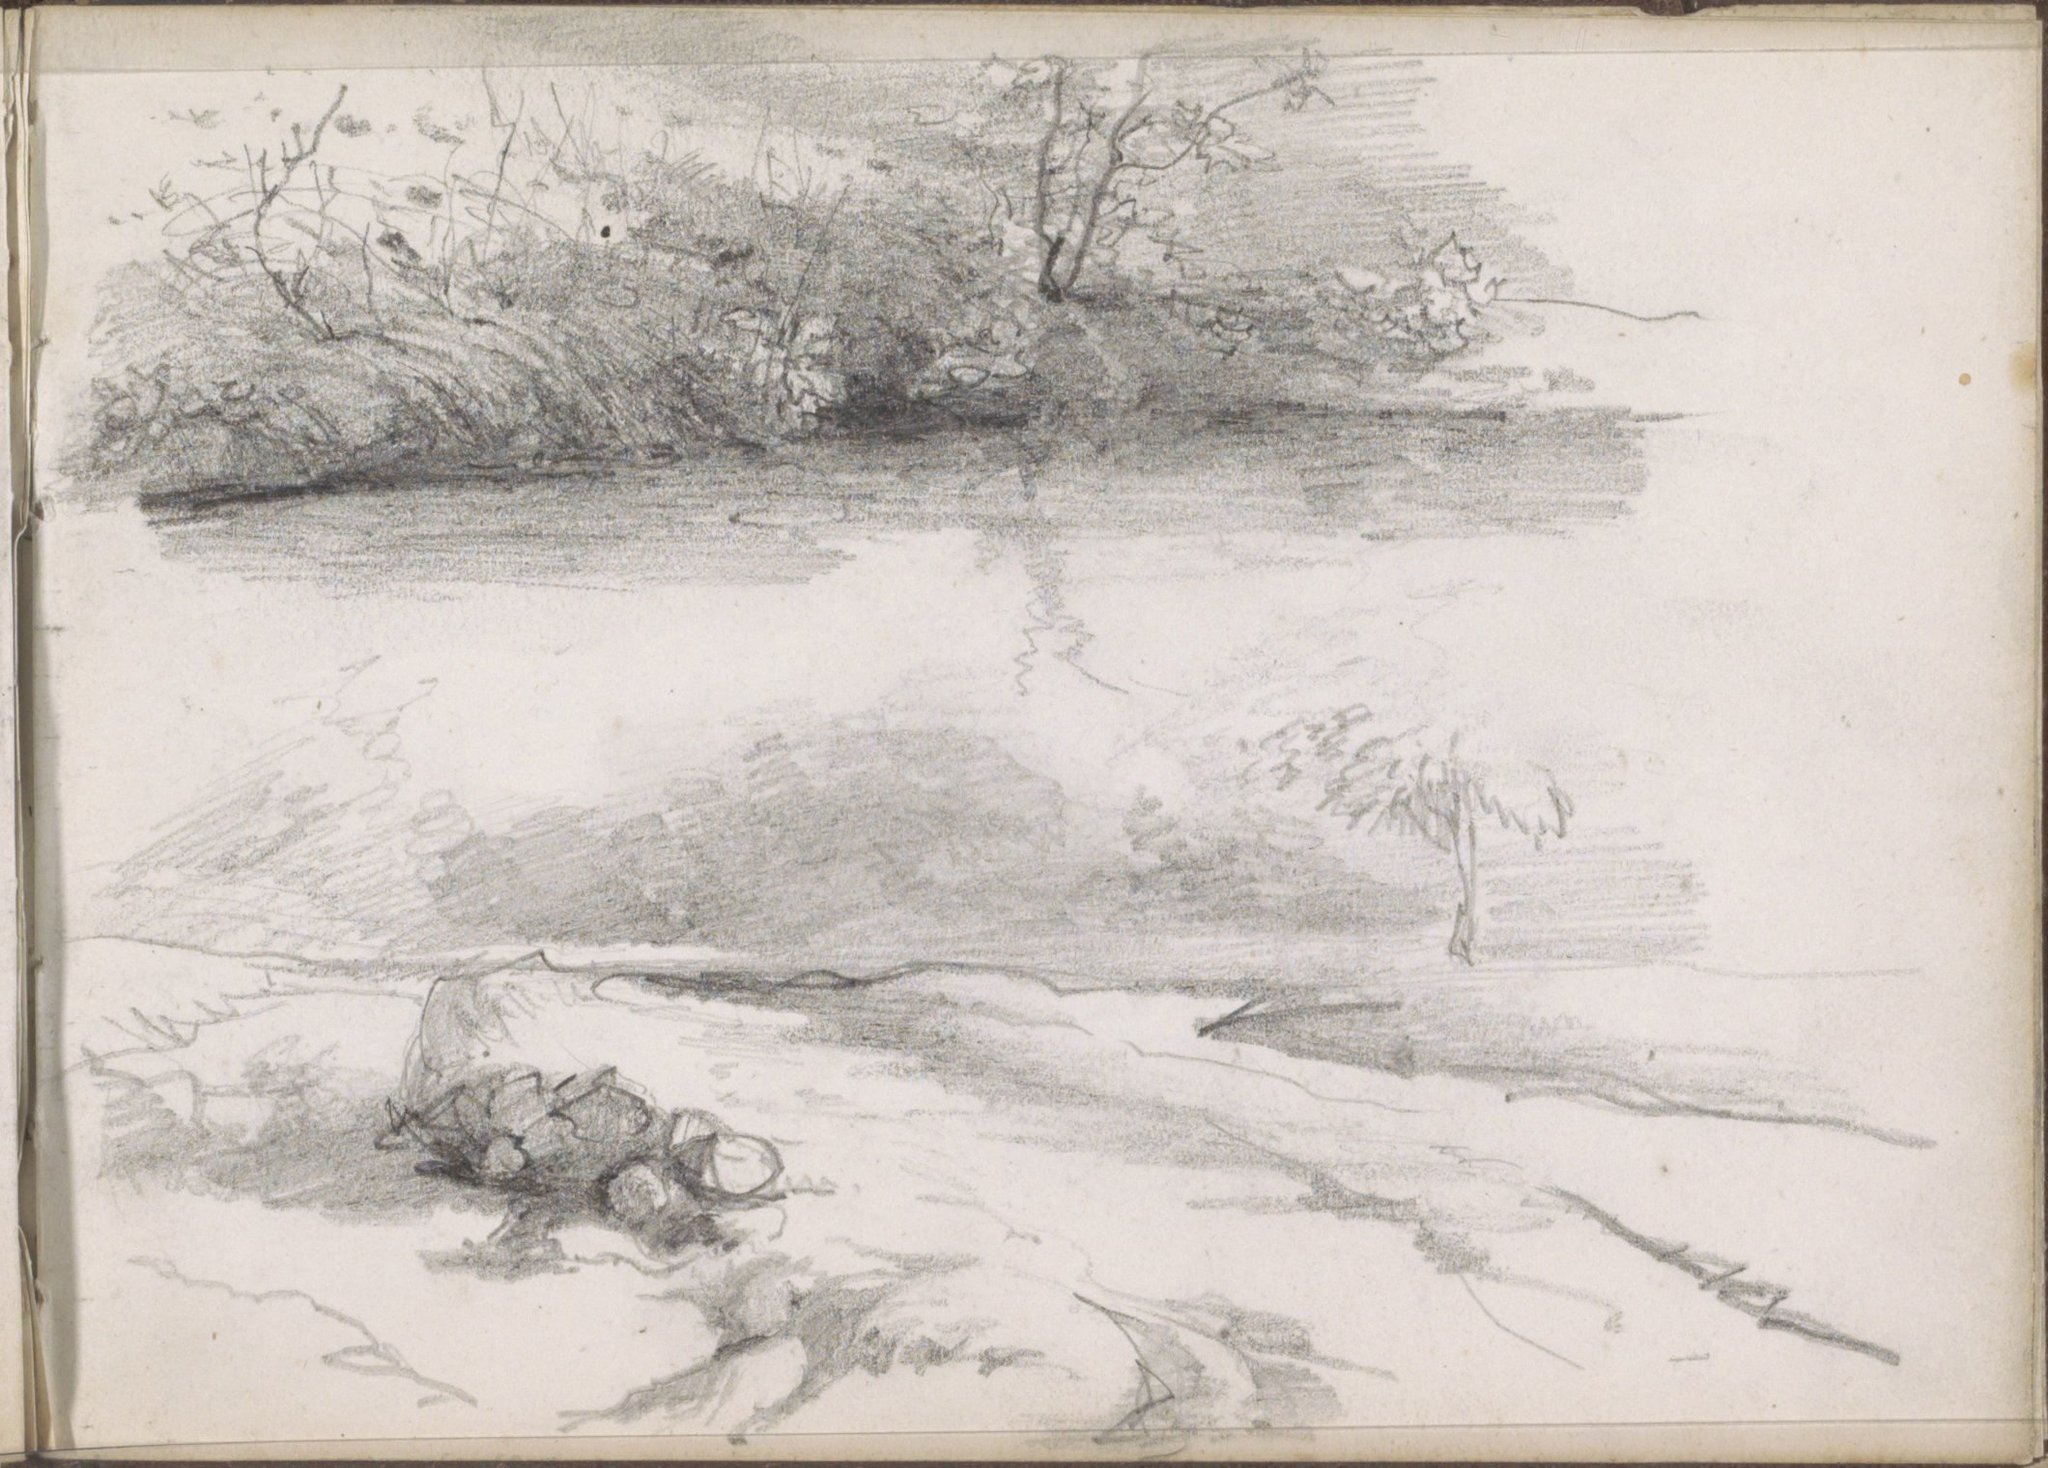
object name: sketchbook leaf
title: Rivierlandschap en een oever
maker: maria vos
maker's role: draughtsman, painter, print maker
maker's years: 1824-1906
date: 1834-1906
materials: paper, pencil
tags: river bank, landscapes with waters, waterscapes, seascapes (in the temperate zone)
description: Blad 30 recto uit een schetsboek met 30 bladen.